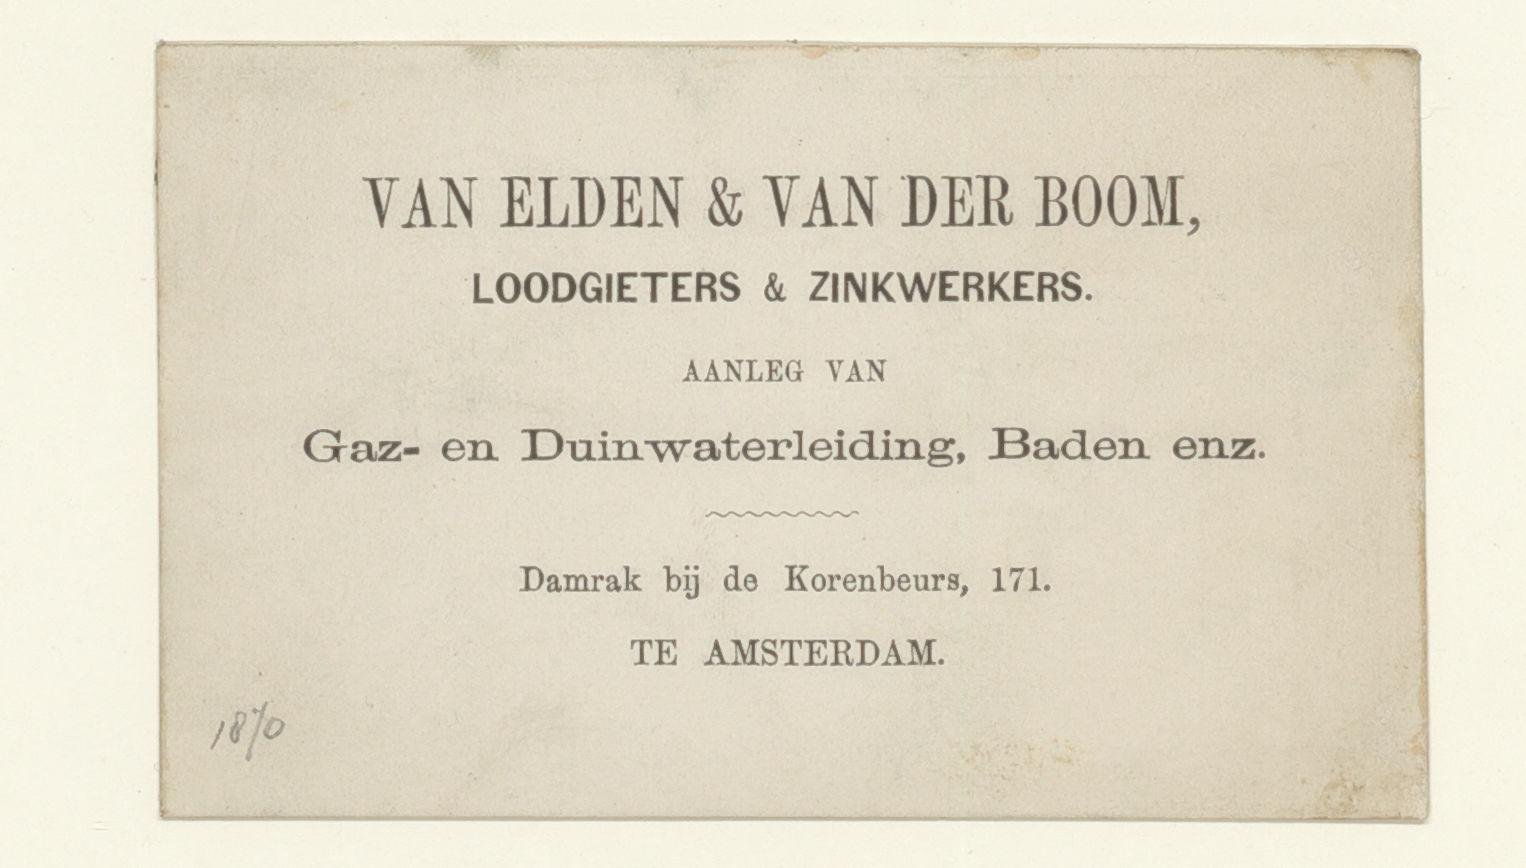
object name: text sheet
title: Visitekaartje van Van Elden & Van der Boom, loodgieters zinkwerkers en leijendekkers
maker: Anonymous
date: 1870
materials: paper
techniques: letterpress printing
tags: amsterdam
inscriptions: stamp, collector's mark: Lugt 1641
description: Visitekaartje van Van Elden & Van der Boom, loodgieters en zinkwerkers. Daarnaast leggen ze gas- en duinwaterleidingen en baden aan. Onderwerpsrubrieken binnen de Atlas Zeden en Gewoonten: Handel, nijverheid en verkeer, Koophandel, Veilingen, Makelaardij en Verzekeringswezen, Oude adreskaarten van winkels en fabrieken, reclame.